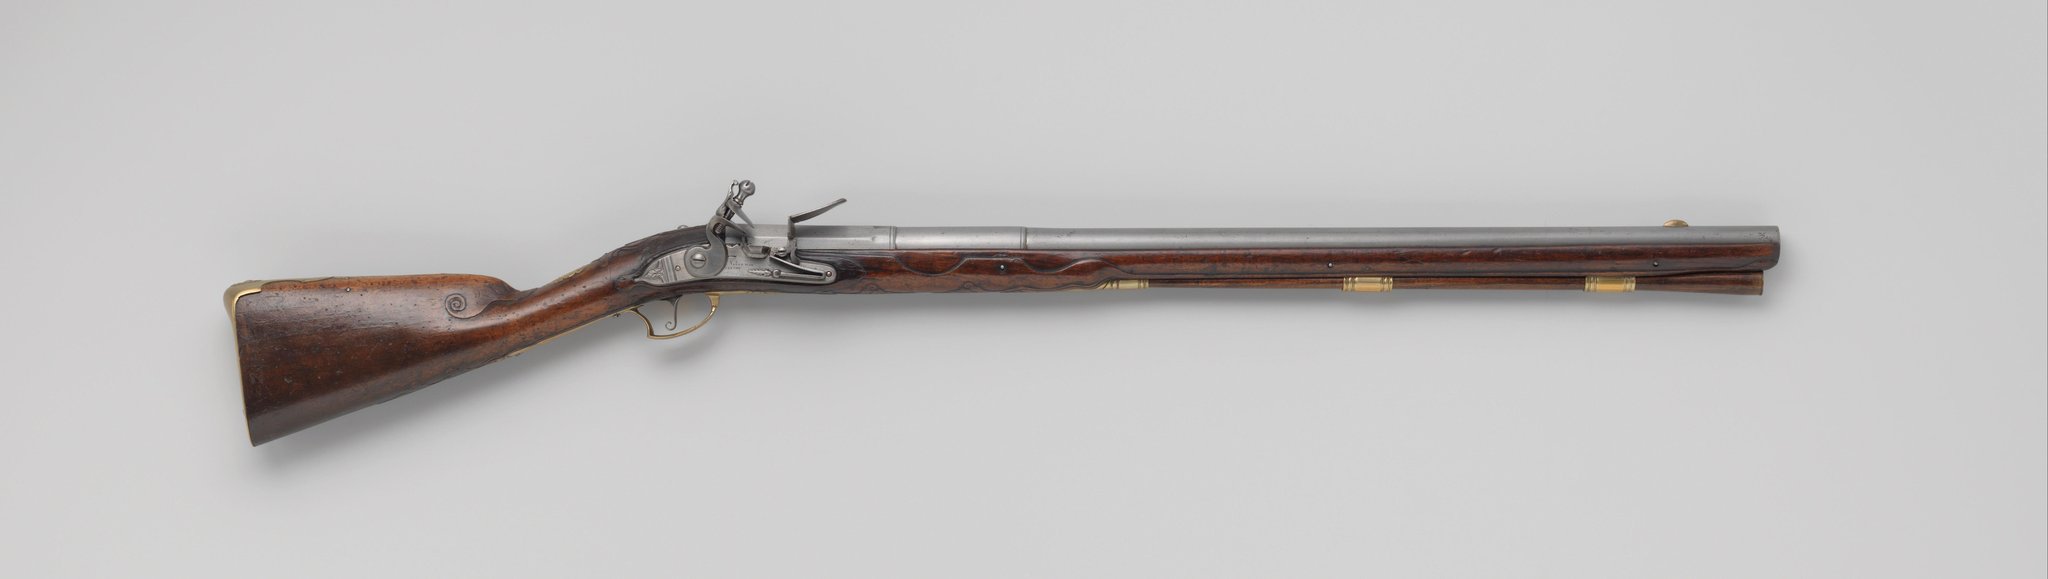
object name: flintlock pistol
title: Geweer met vuursteenslot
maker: jan nelleman (i)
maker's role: geweermaker, pistoolmaker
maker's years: -1690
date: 1800-1825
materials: copper, iron, wood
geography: utrecht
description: Geweer met vuursteenslot en gesneden kolf en lade, koperen montuur. Bij het slot: J.Nelleman, Utrecht. Op de loop een onduidelijk merkteken. Houten laadstok.